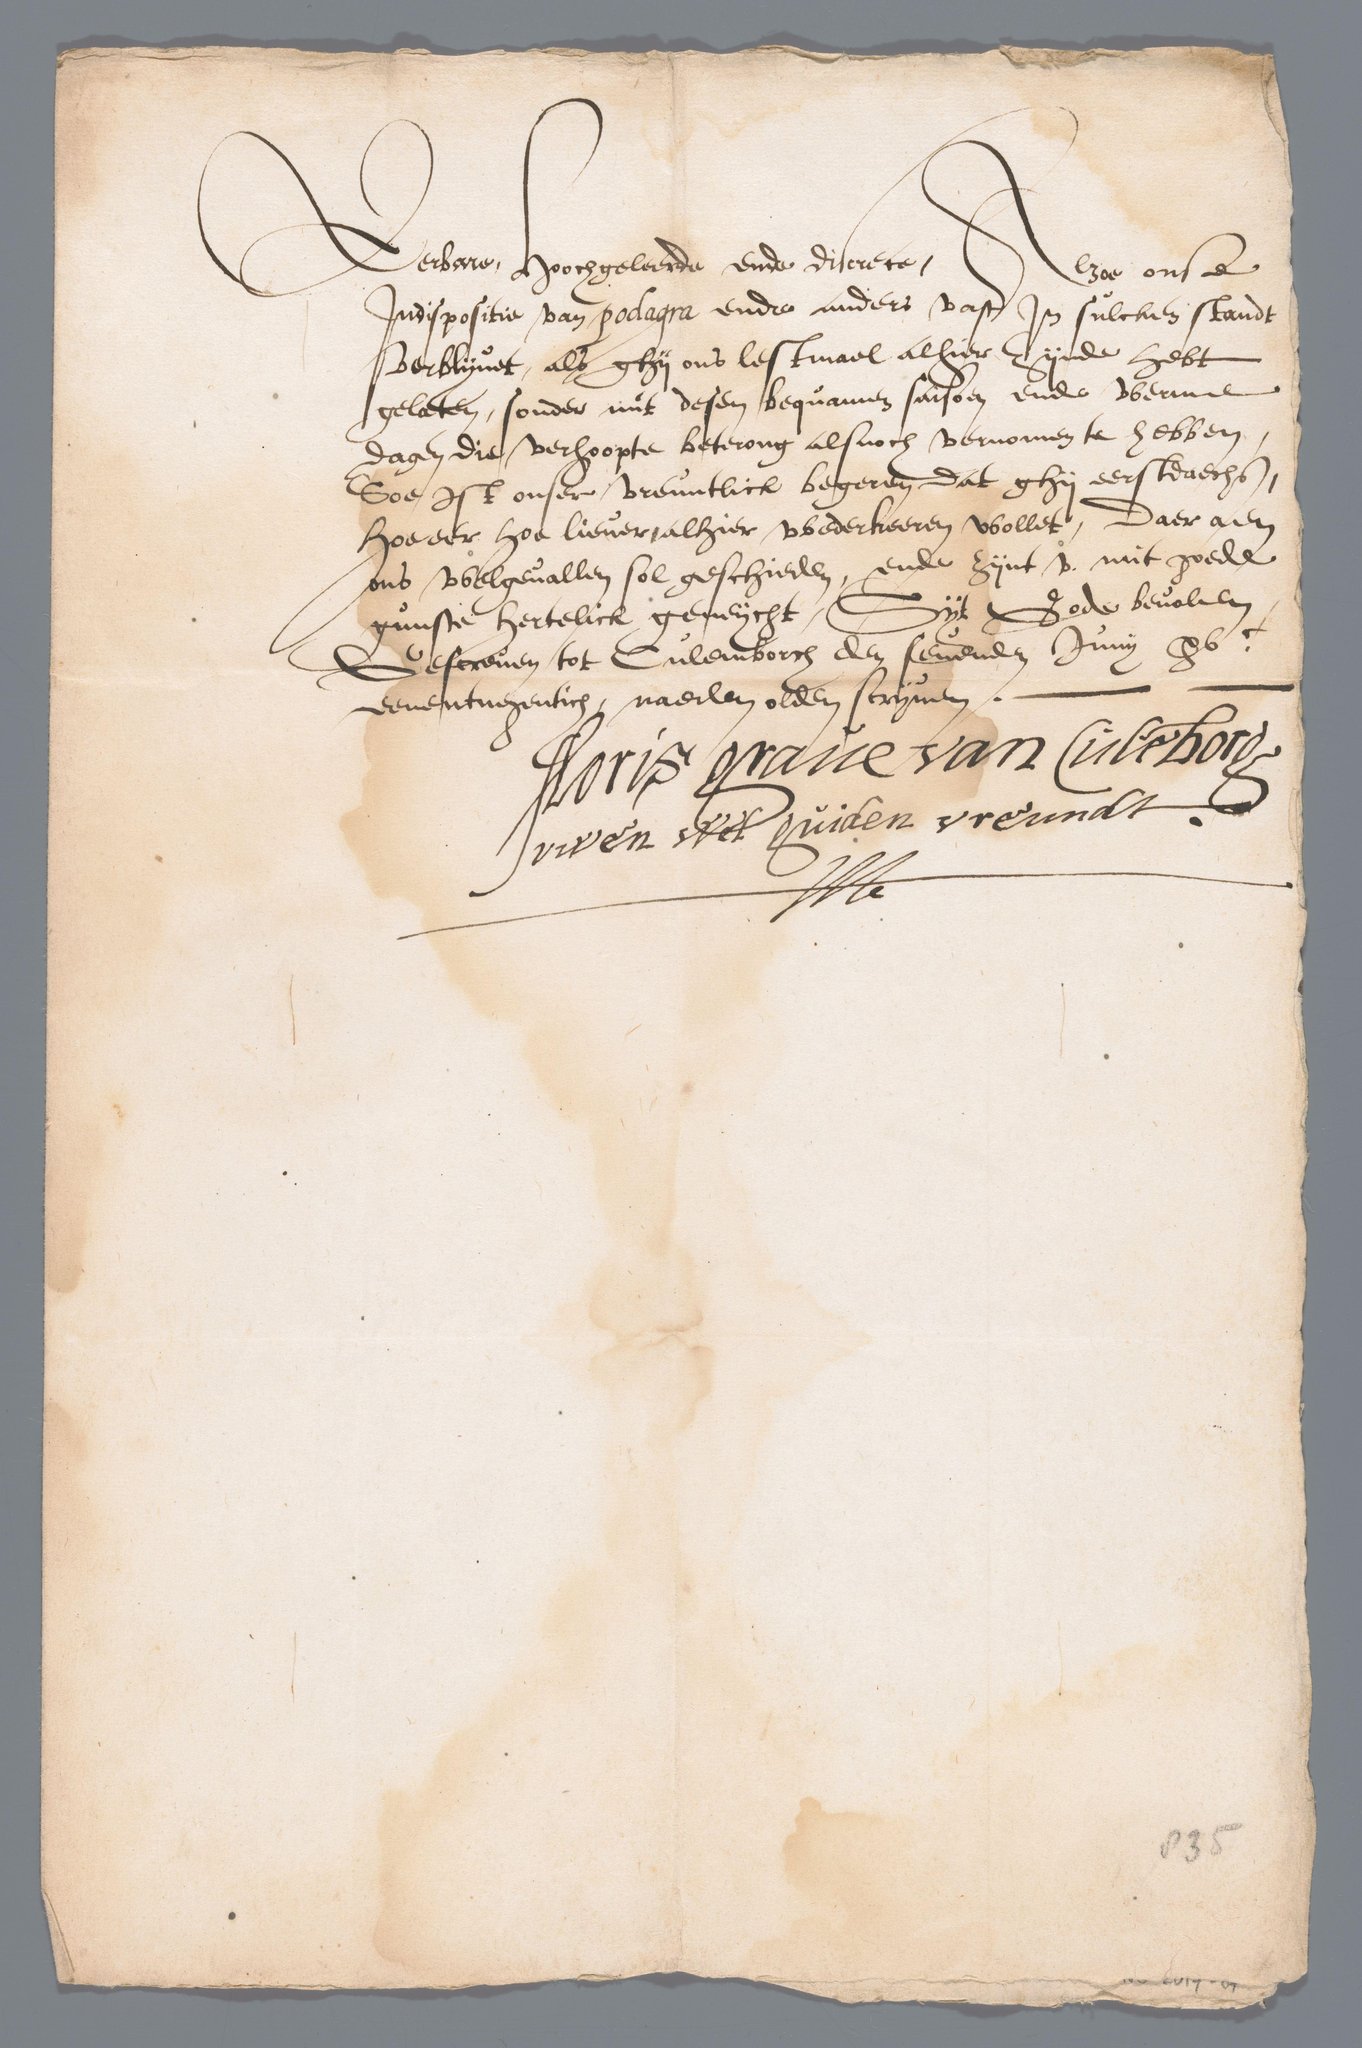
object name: document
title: Brief van Floris van Pallandt, graaf van Culemborg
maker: floris van pallandt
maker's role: earl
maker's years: 1539-1598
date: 1591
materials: ink, paper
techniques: writing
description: Handgeschreven brief, ondertekend door Floris van Pallandt, graaf van Culemborg, met adressering aan dokter Marthen Schipperius (Utrecht), 7-6-1591 (O.S.).